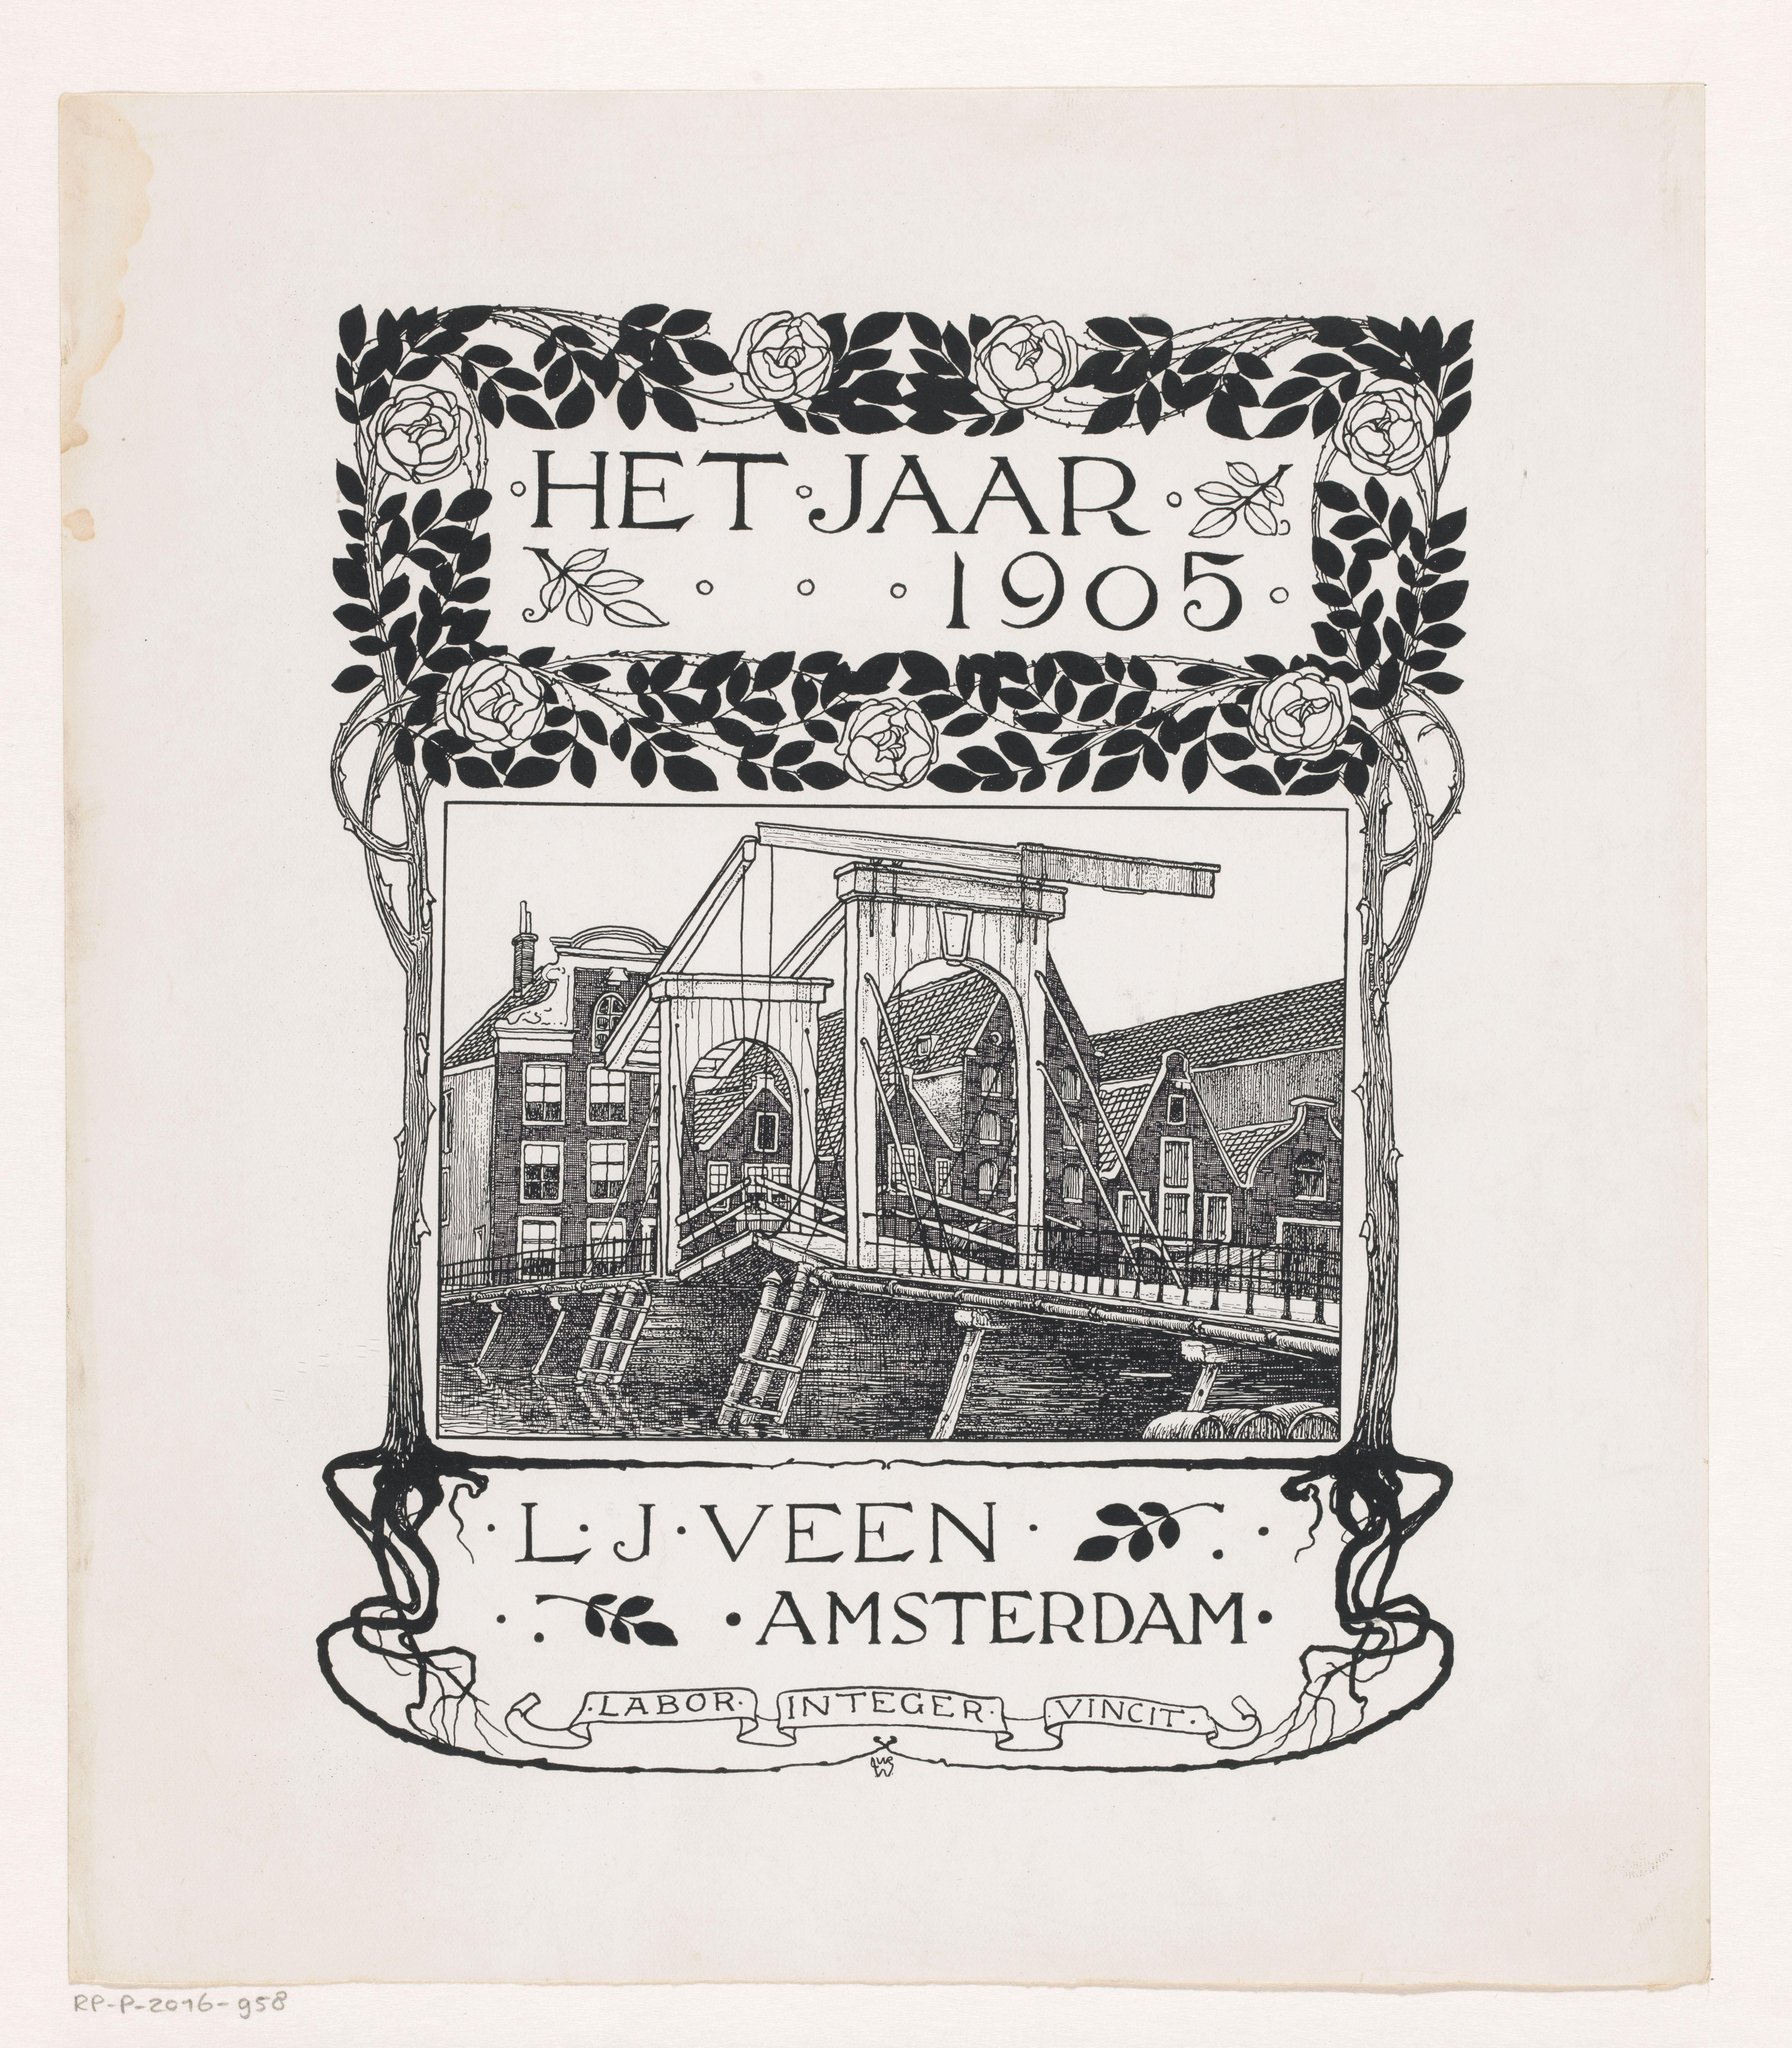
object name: design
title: Omslagontwerp voor: Het jaar 1905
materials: paper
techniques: printing block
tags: canals, waters (in city), flowers ~ ornament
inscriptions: collector's mark: Lugt 2228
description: Gezicht op een ophaalbrug over een kanaal. In de achtergrond zijn rijtjeshuizen met verschillende gevels te zien. Onder de voorstelling de vermelding van Uitgeversmaatschappij L.J. Veen en de spreuk 'Labor Integer Vincit' in drie spreukbanden. Aan weerszijden hiervan de wortels en stammen van een rozenstruik die langs de voorstelling omhoog groeien en daarboven een motief vormen van rozen en bladeren die de tekst 'Het jaar 1905' omsluiten.